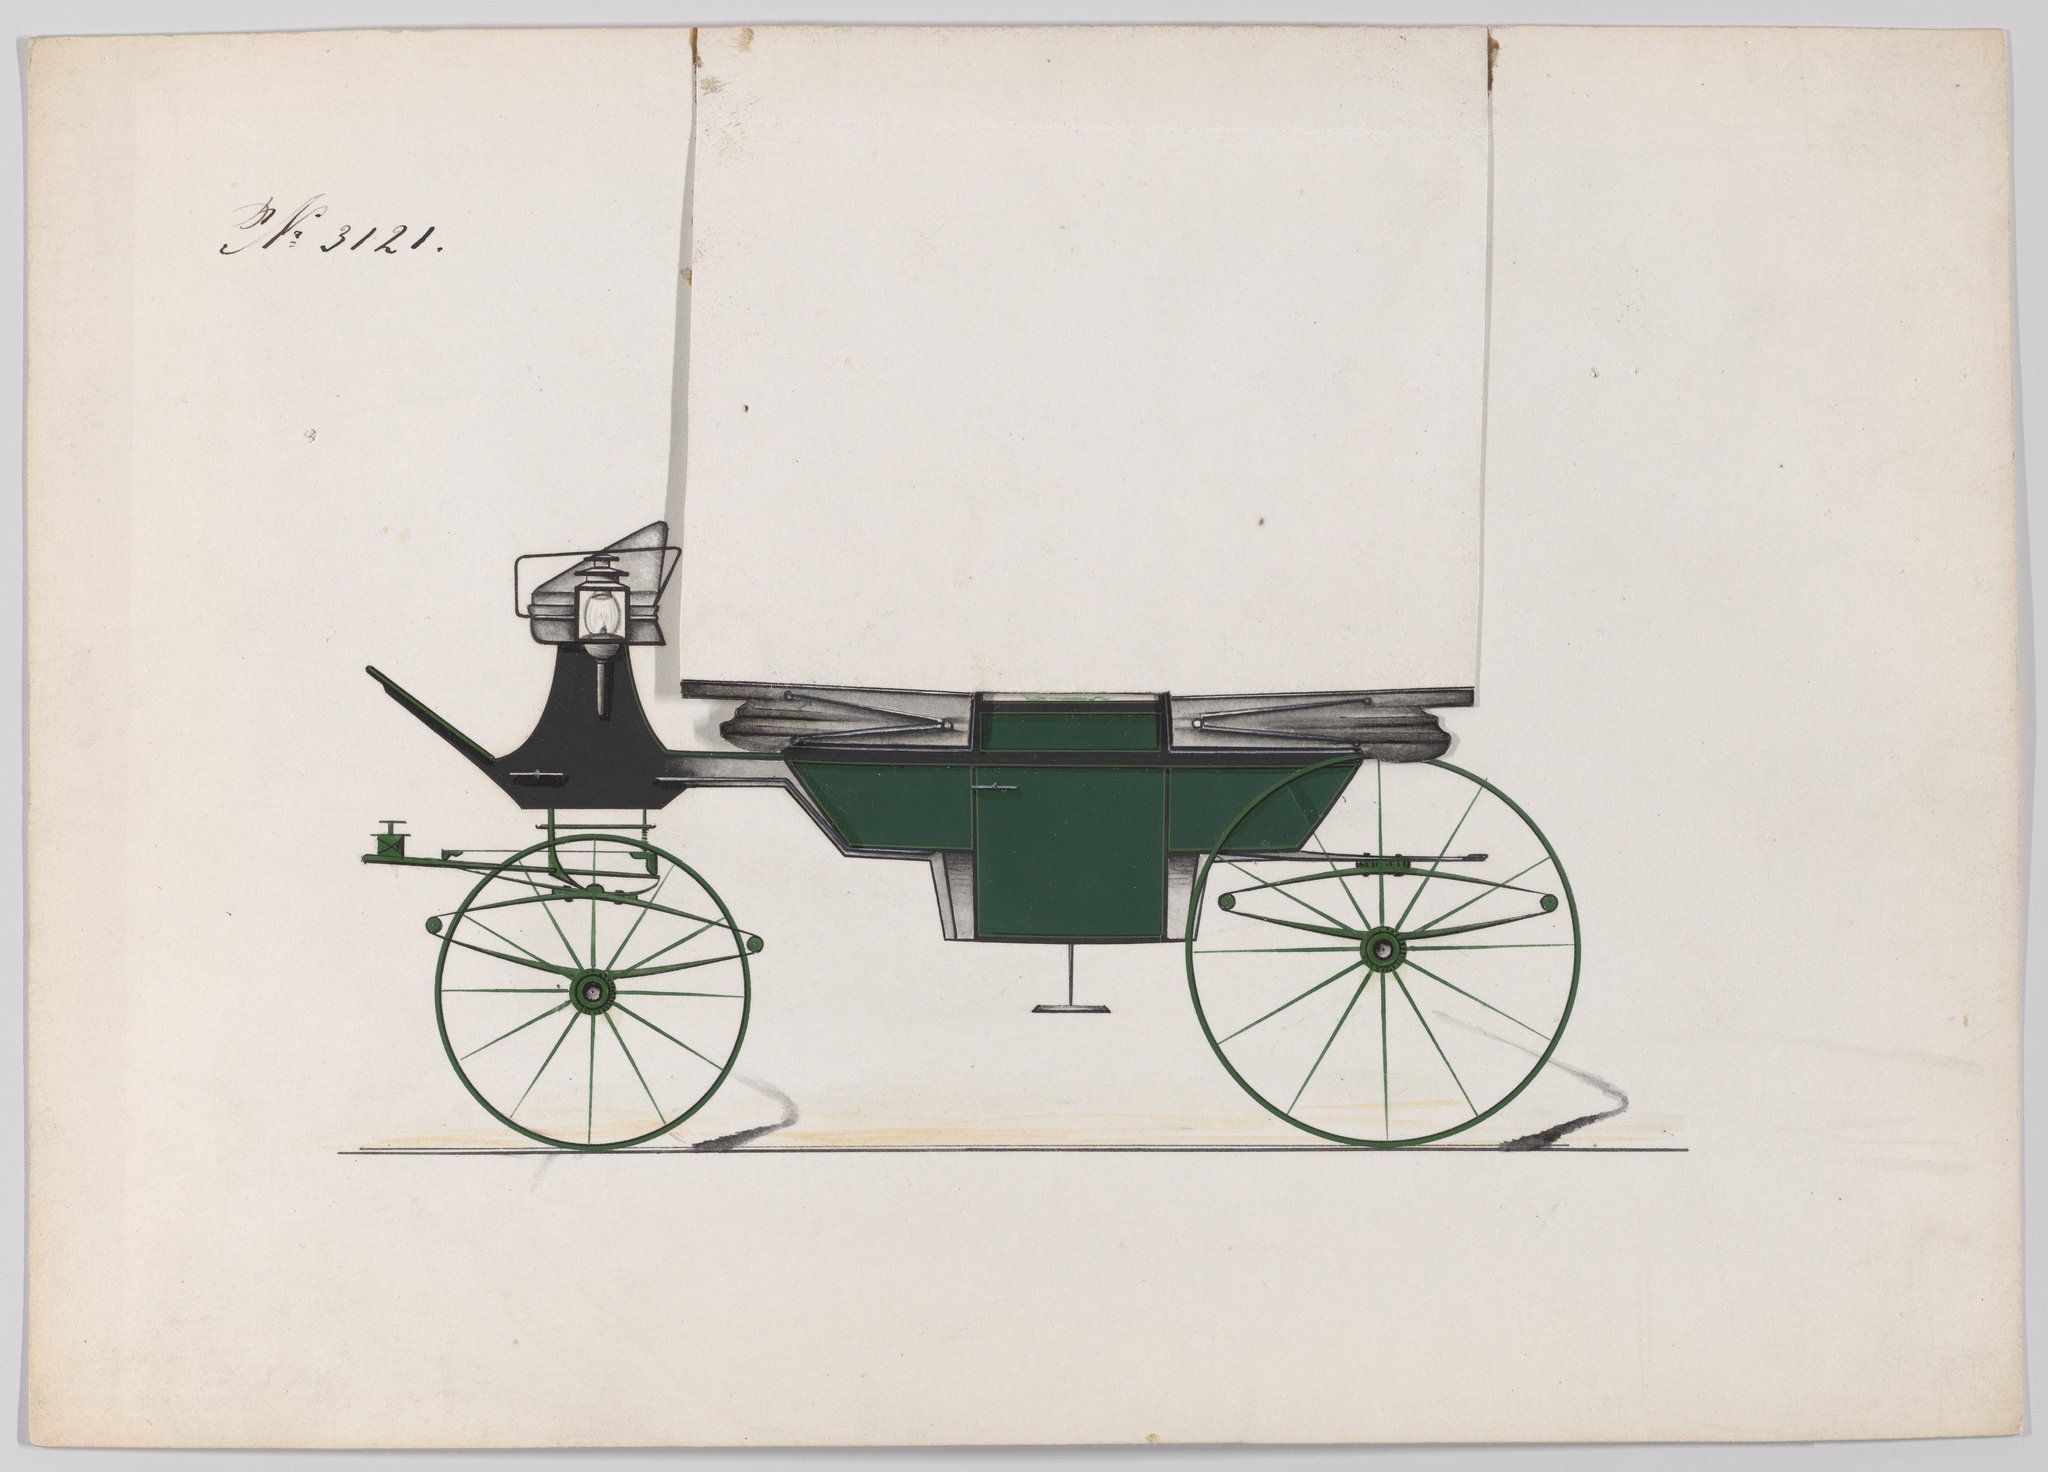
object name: drawing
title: Design for Landau, No. 3121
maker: brewster & co.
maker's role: manufacturer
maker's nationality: american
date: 1875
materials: gouache, gum arabic, ink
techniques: pen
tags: carriages